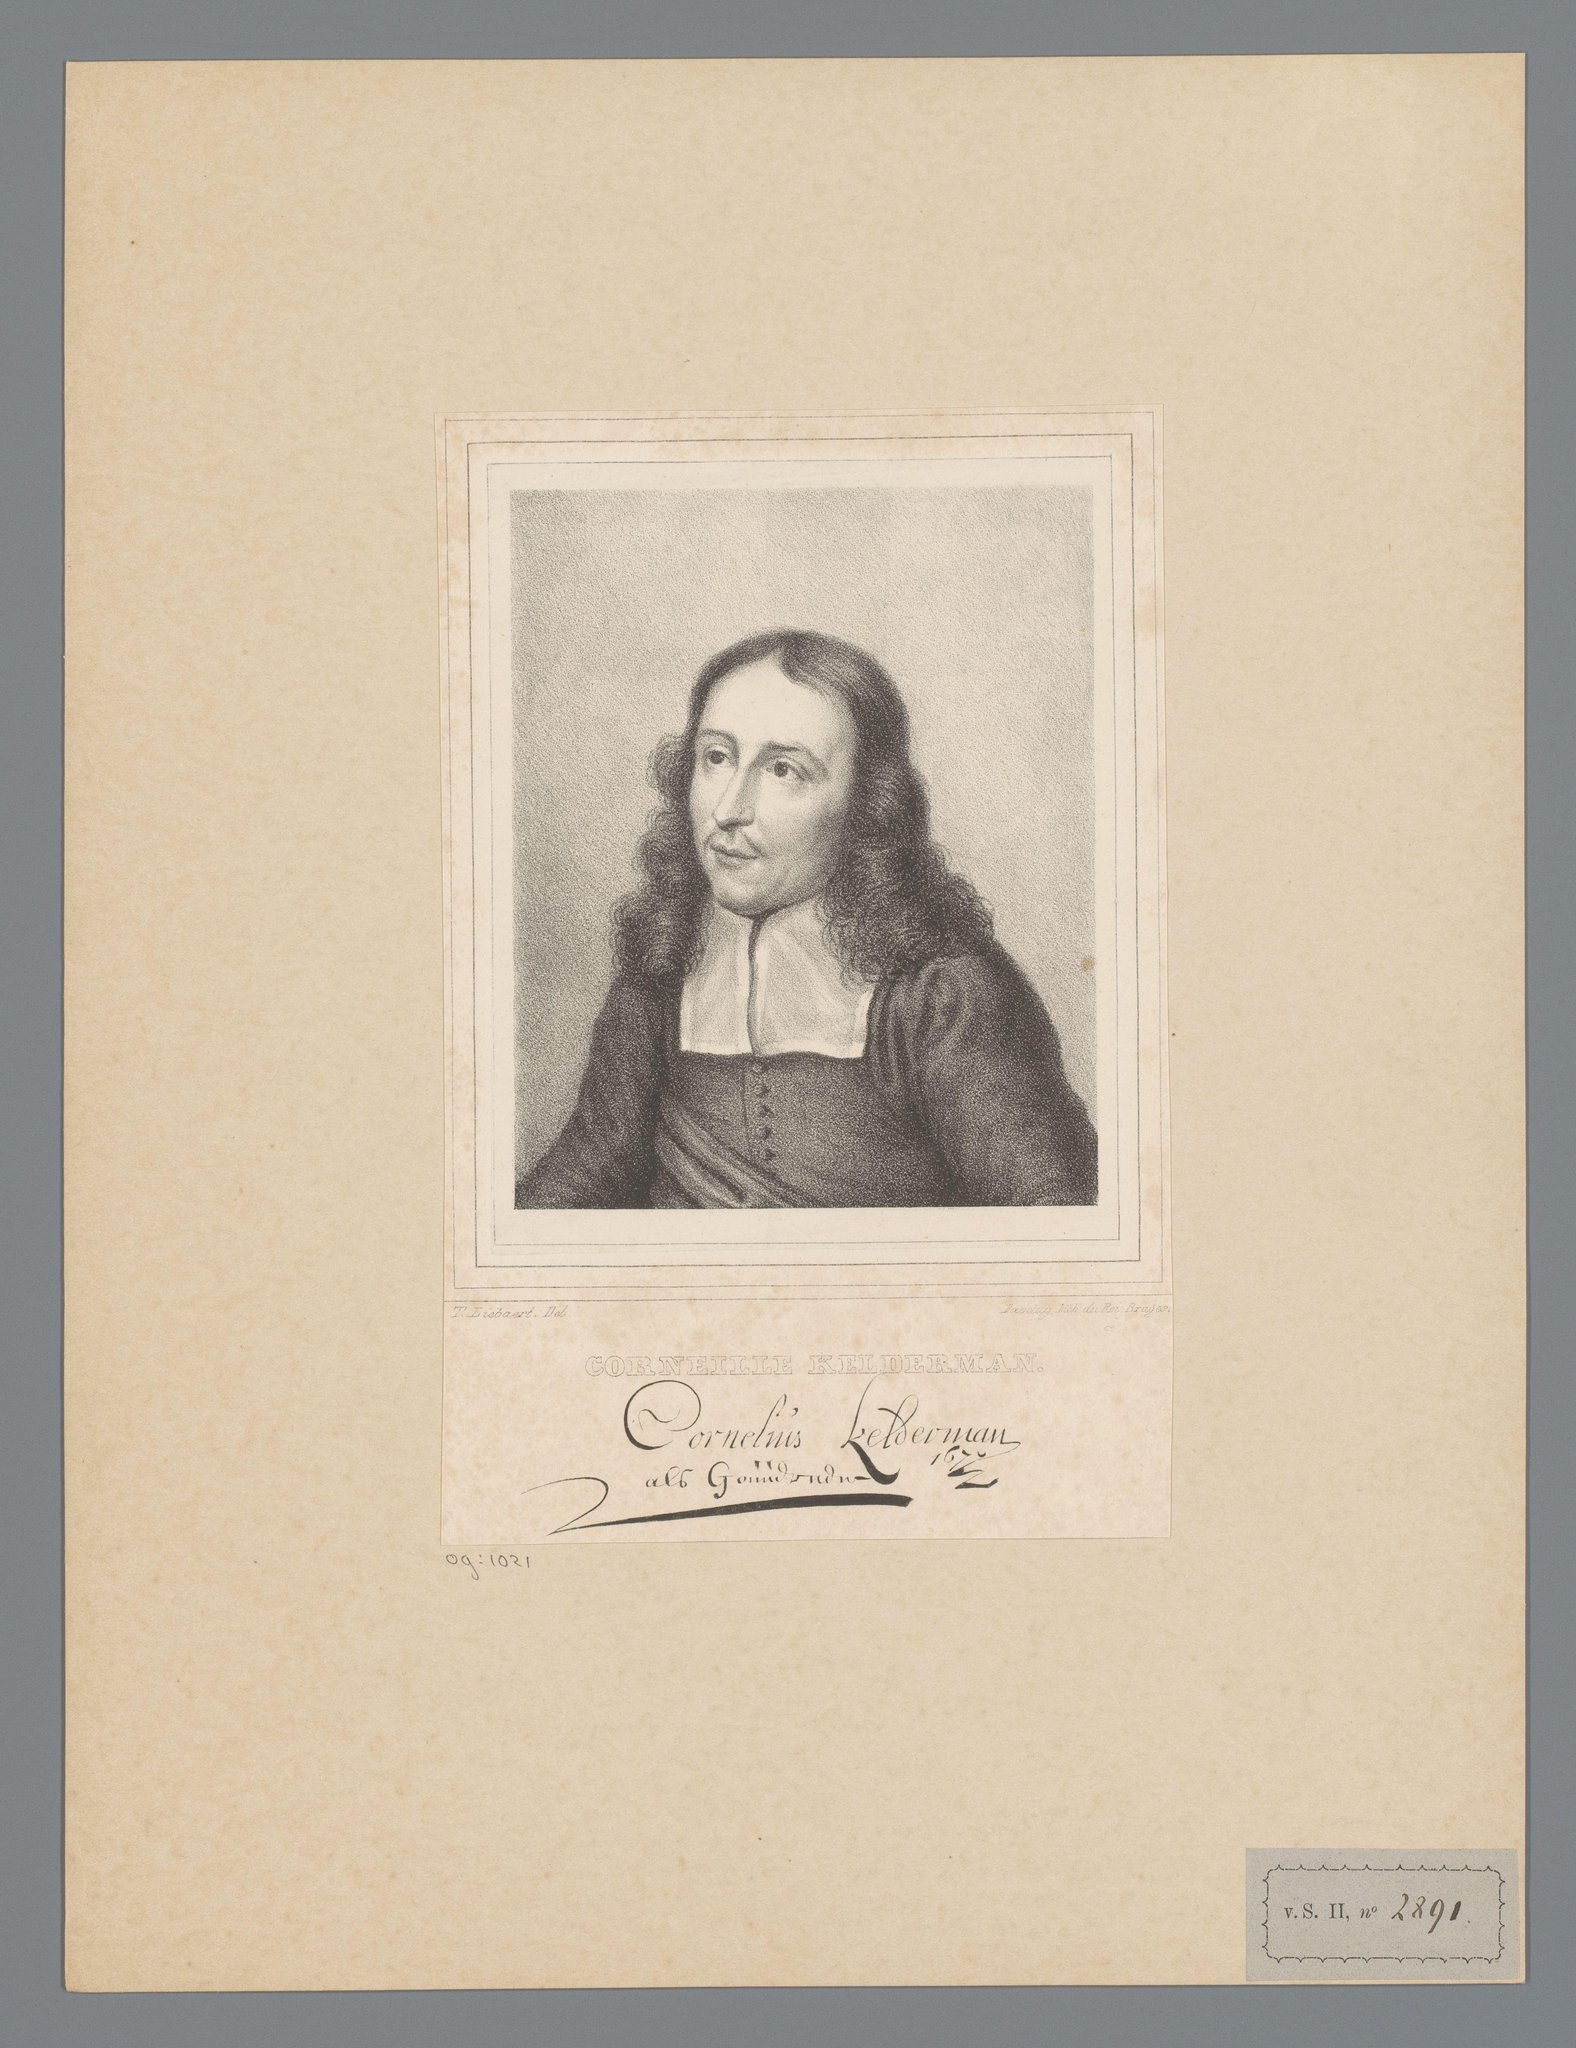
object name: print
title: Corneille Kelderman. Cornelius Kelderman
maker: edouard-alexis daveluy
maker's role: print maker, printer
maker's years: 1812-1894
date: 1835-1874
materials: paper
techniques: lithograph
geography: bruges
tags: historical persons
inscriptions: collector's mark: Lugt 2228, label: ‘v.S. II, no 2891’